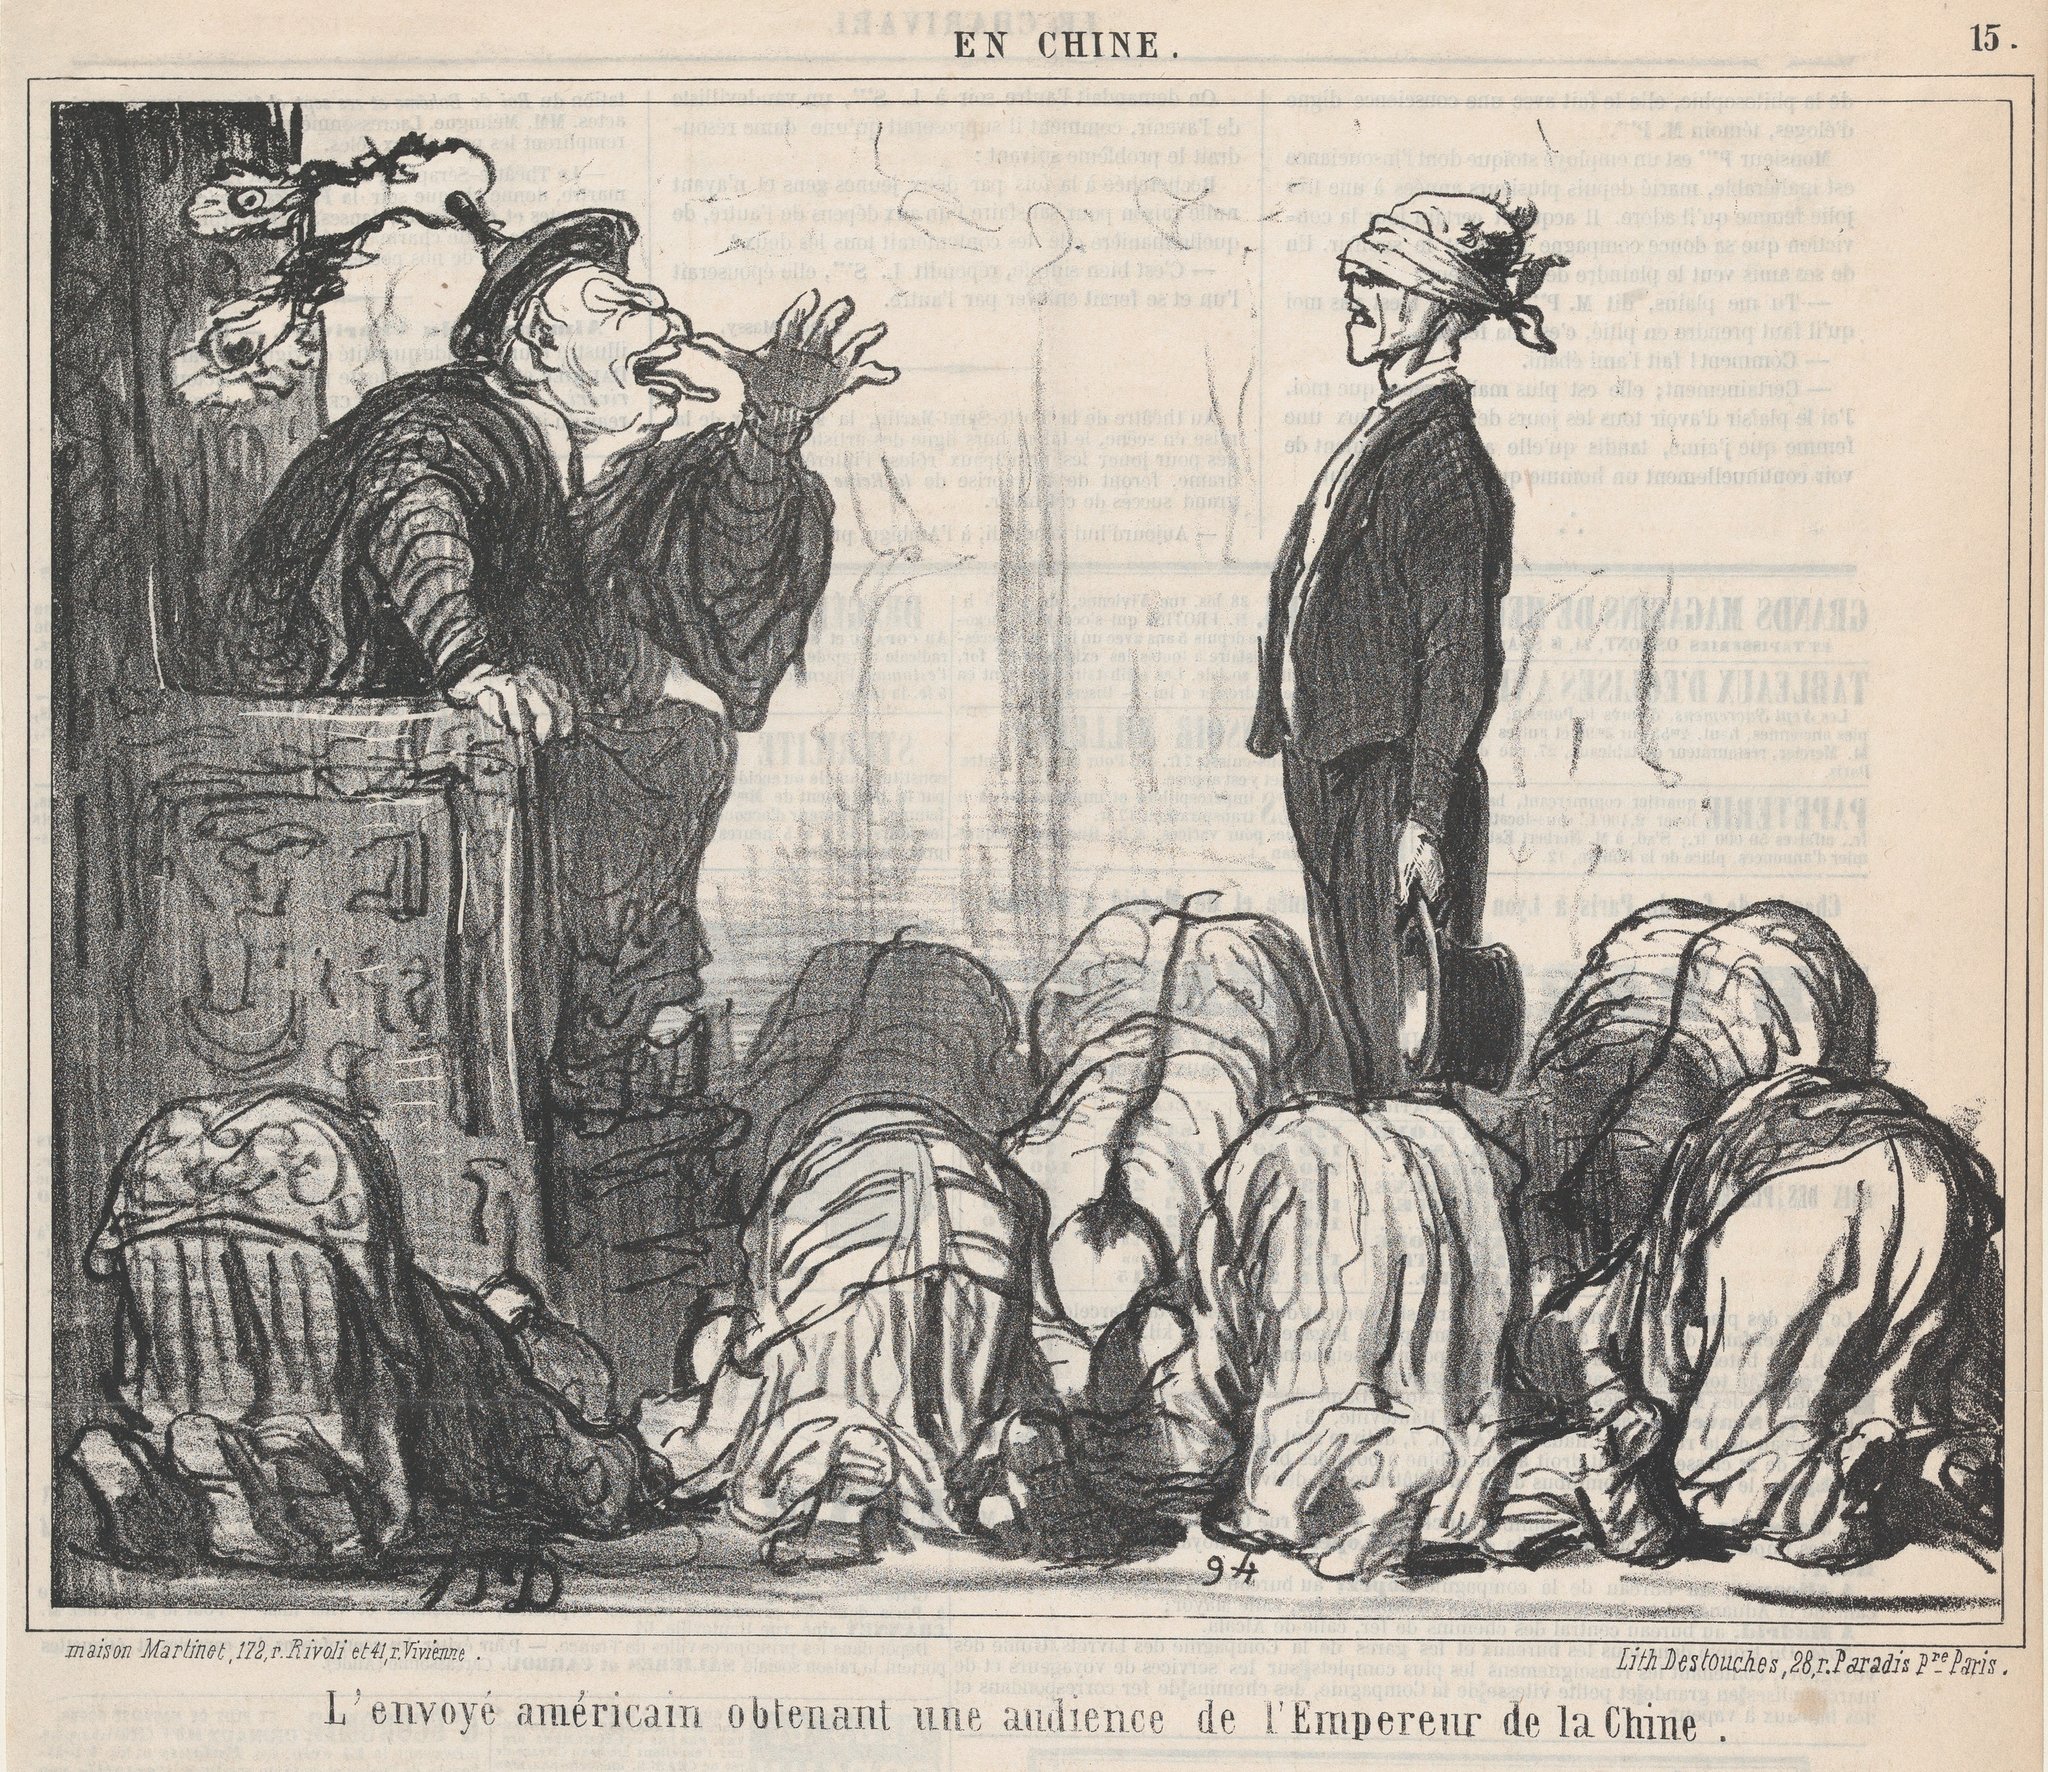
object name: print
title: L'envoyé américain obtenant une audience de l'Empereur de la Chine...., from En Chine, published in Le Charivari, October 21, 1859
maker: honoré daumier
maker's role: artist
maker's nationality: french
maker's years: 1808-1879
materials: paper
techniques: lithograph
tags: satire,men